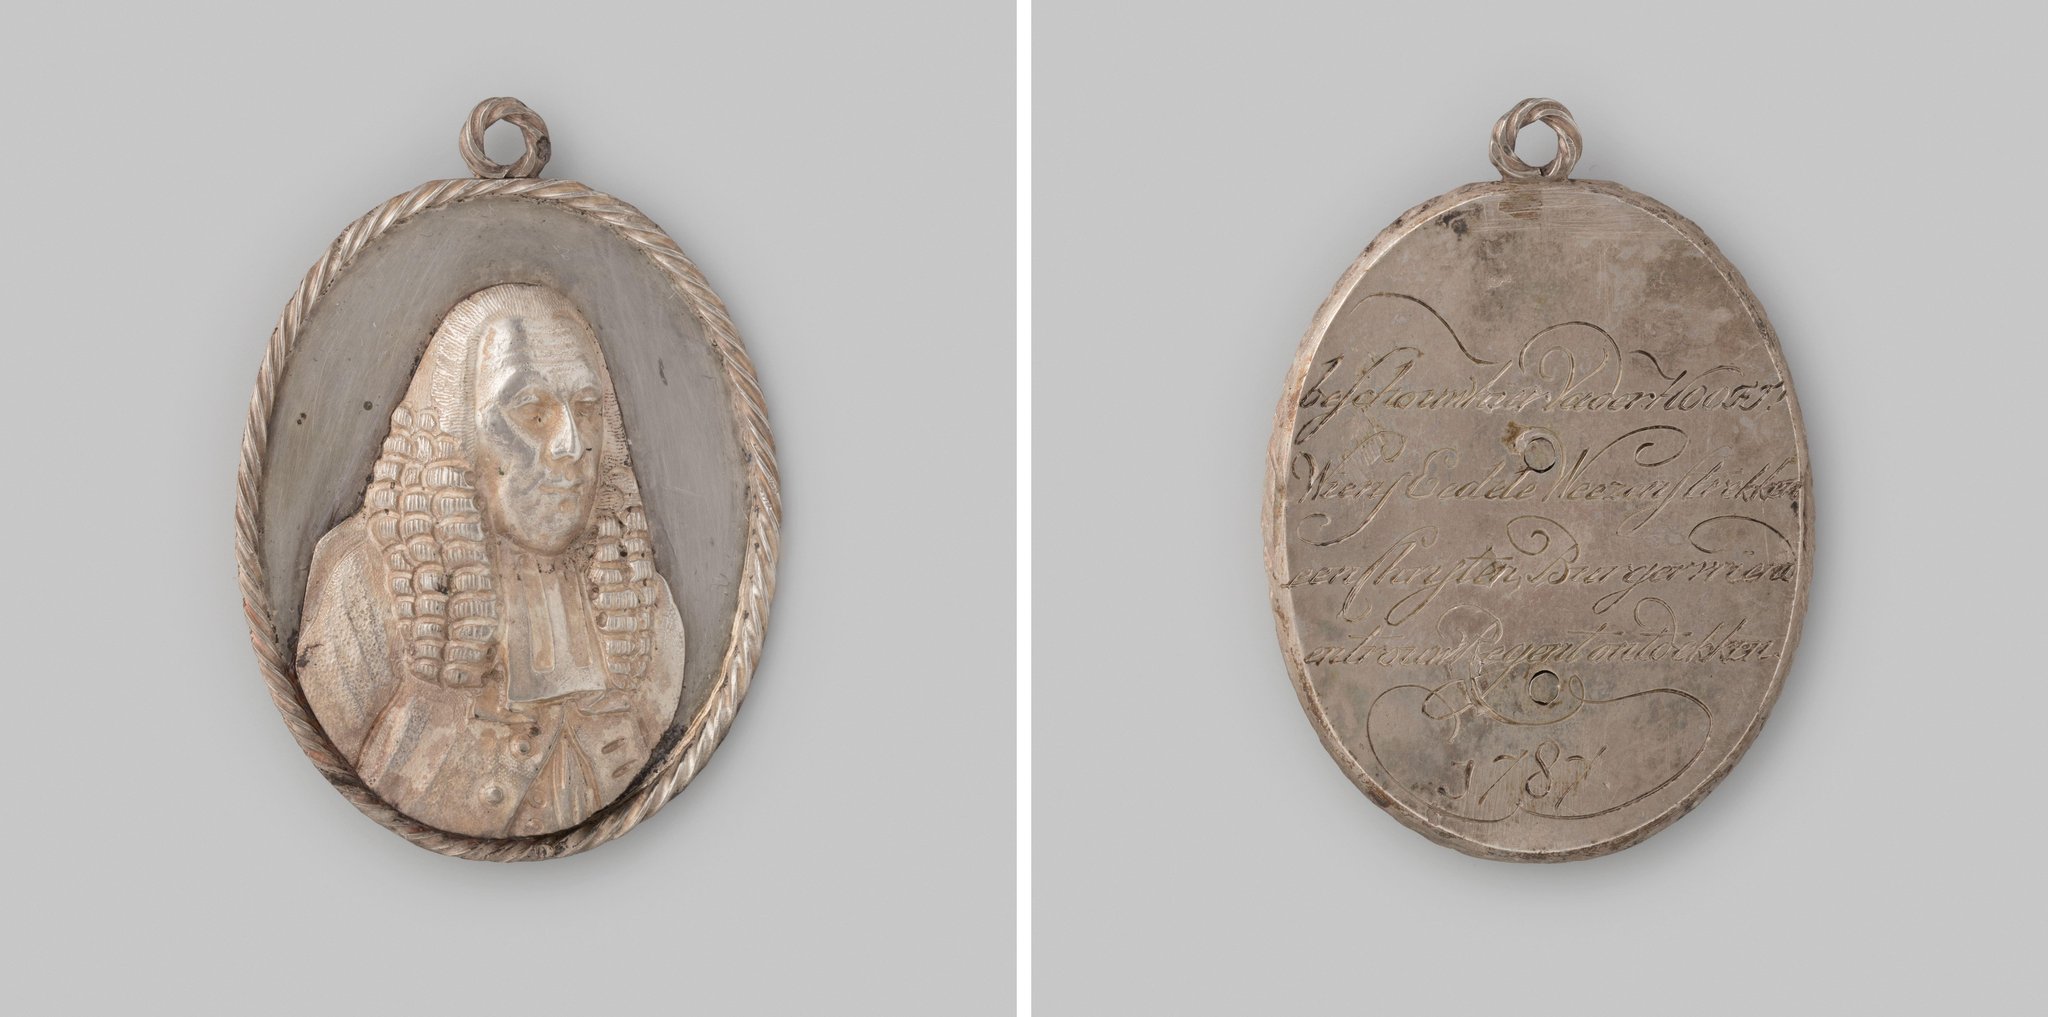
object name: insignia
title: Hendrik Danielsz. Hooft, burgemeester van Amsterdam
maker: Anonymous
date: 1787-1794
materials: silver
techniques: engraving, fastening, soldering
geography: netherlands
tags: hendrik danielsz. hooft, amsterdam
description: Zilveren ovale draagteken met kabelrand aan draagoog. Voorzijde: borststuk man. Keerzijde: opschrift; op keerzijde zijn nog twee nagels zichtbaar, waarmee voor- en keerzijde aan elkaar zijn bevestigd